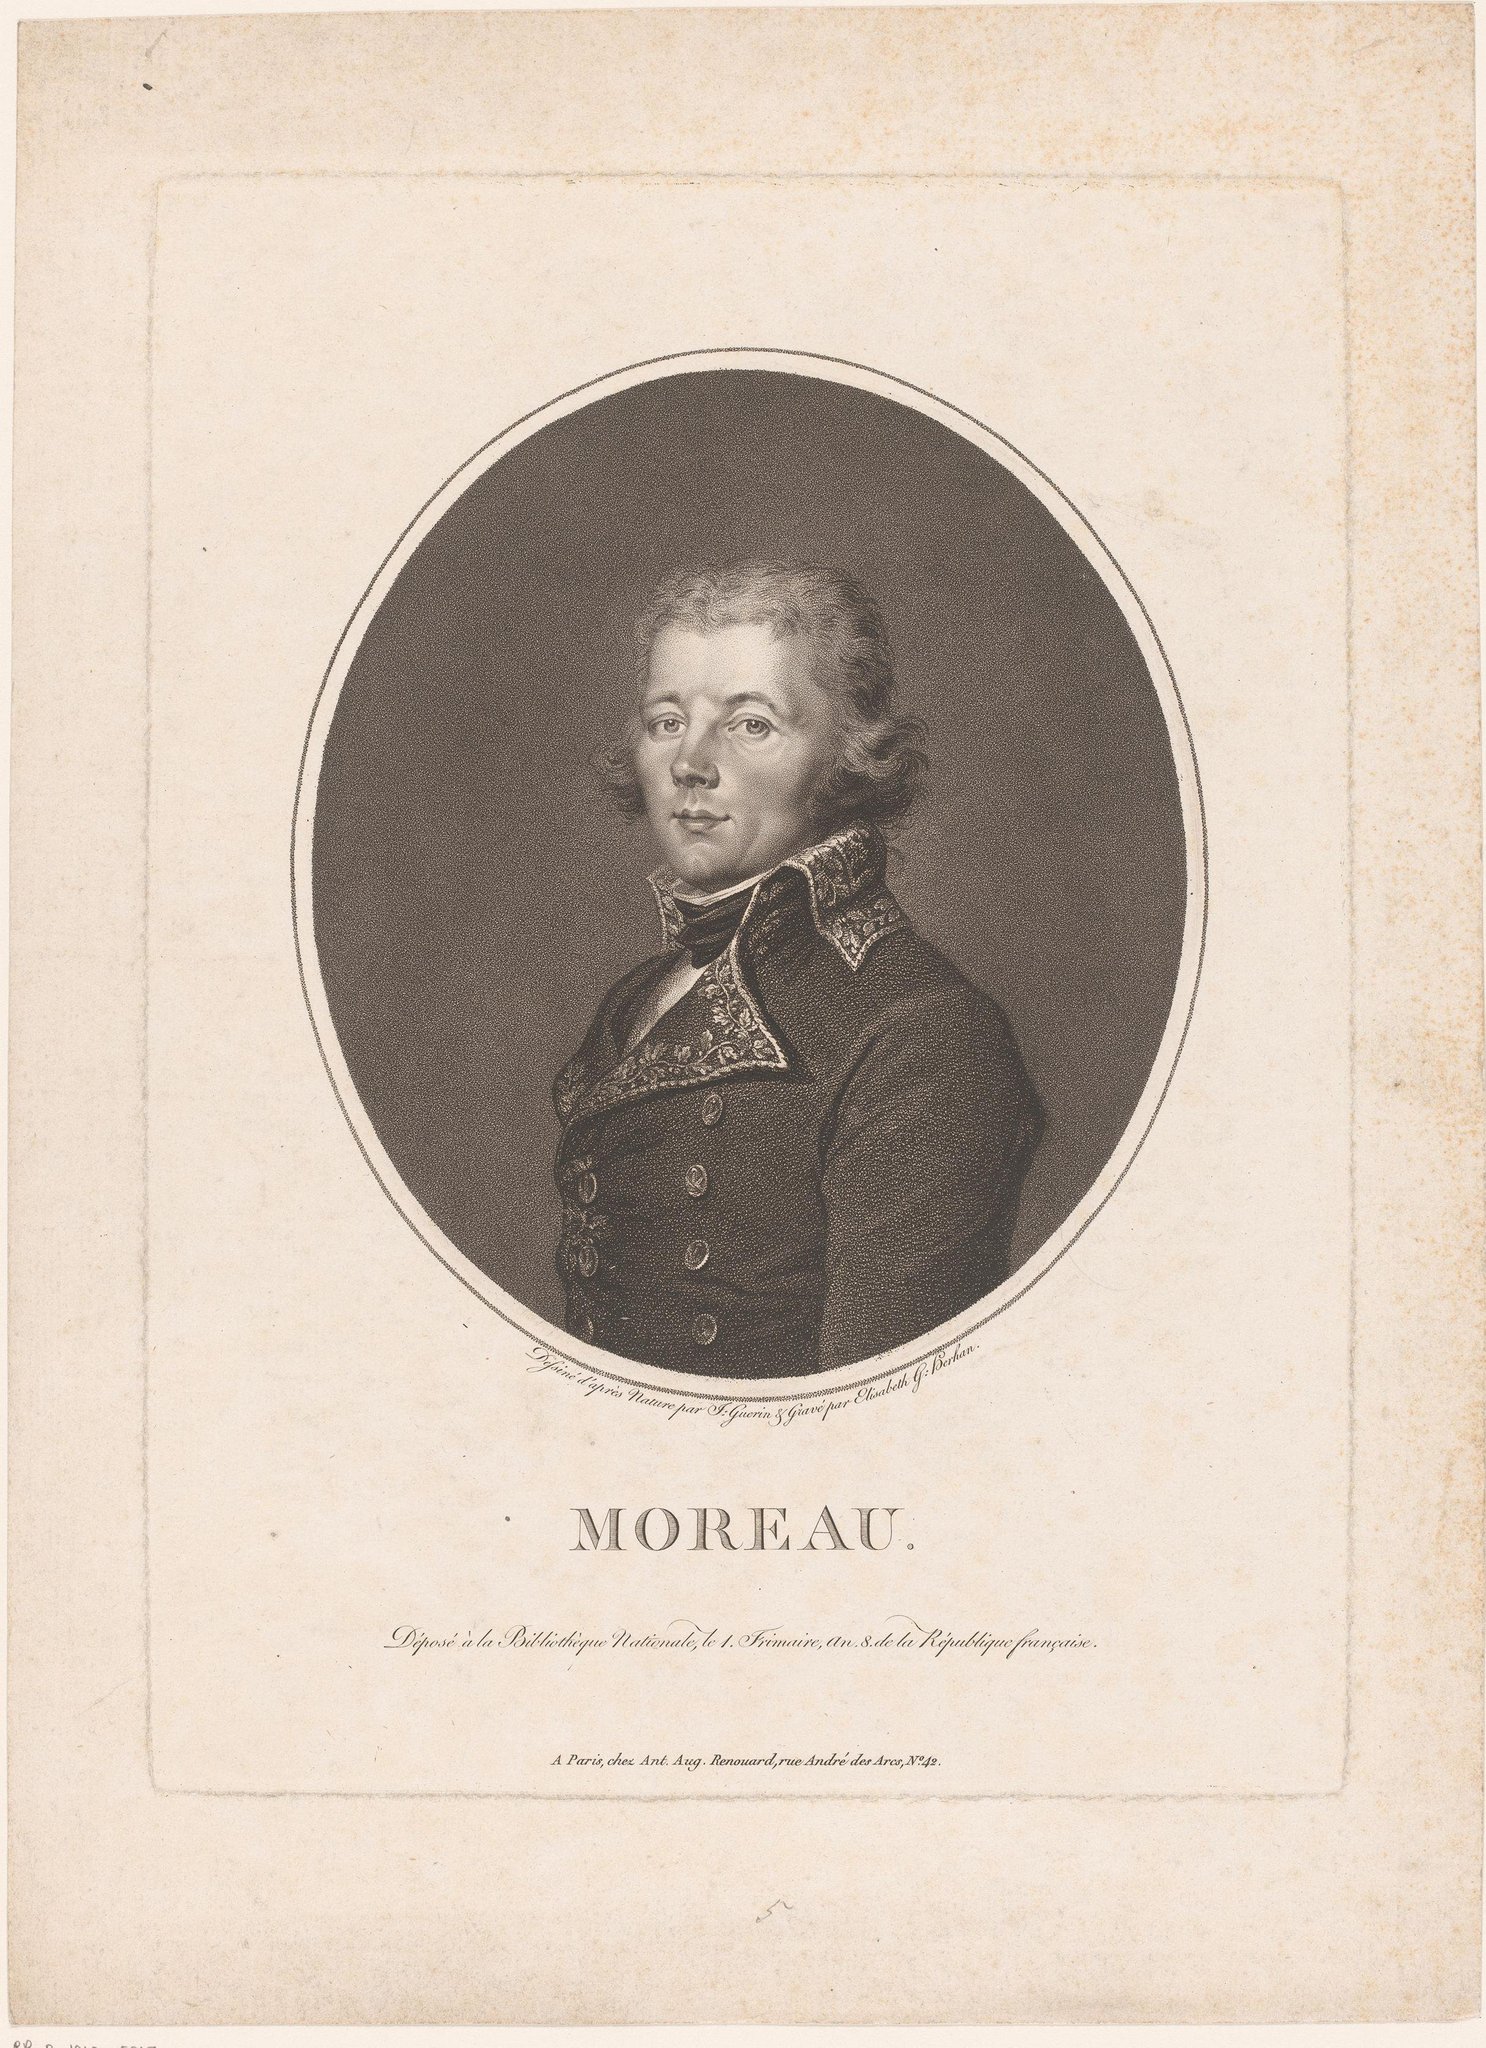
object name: print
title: Portretten van Franse generaals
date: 1798-1801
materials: paper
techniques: engraving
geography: paris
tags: commander-in-chief, general, marshal, historical persons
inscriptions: collector's mark: Lugt 2228, : ‘Déposé à la Bibliothèque Nationale, le 1. Frimaire, An. 8. de la République française.’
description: Maakt deel uit van een serie met portretten van Franse generaals.